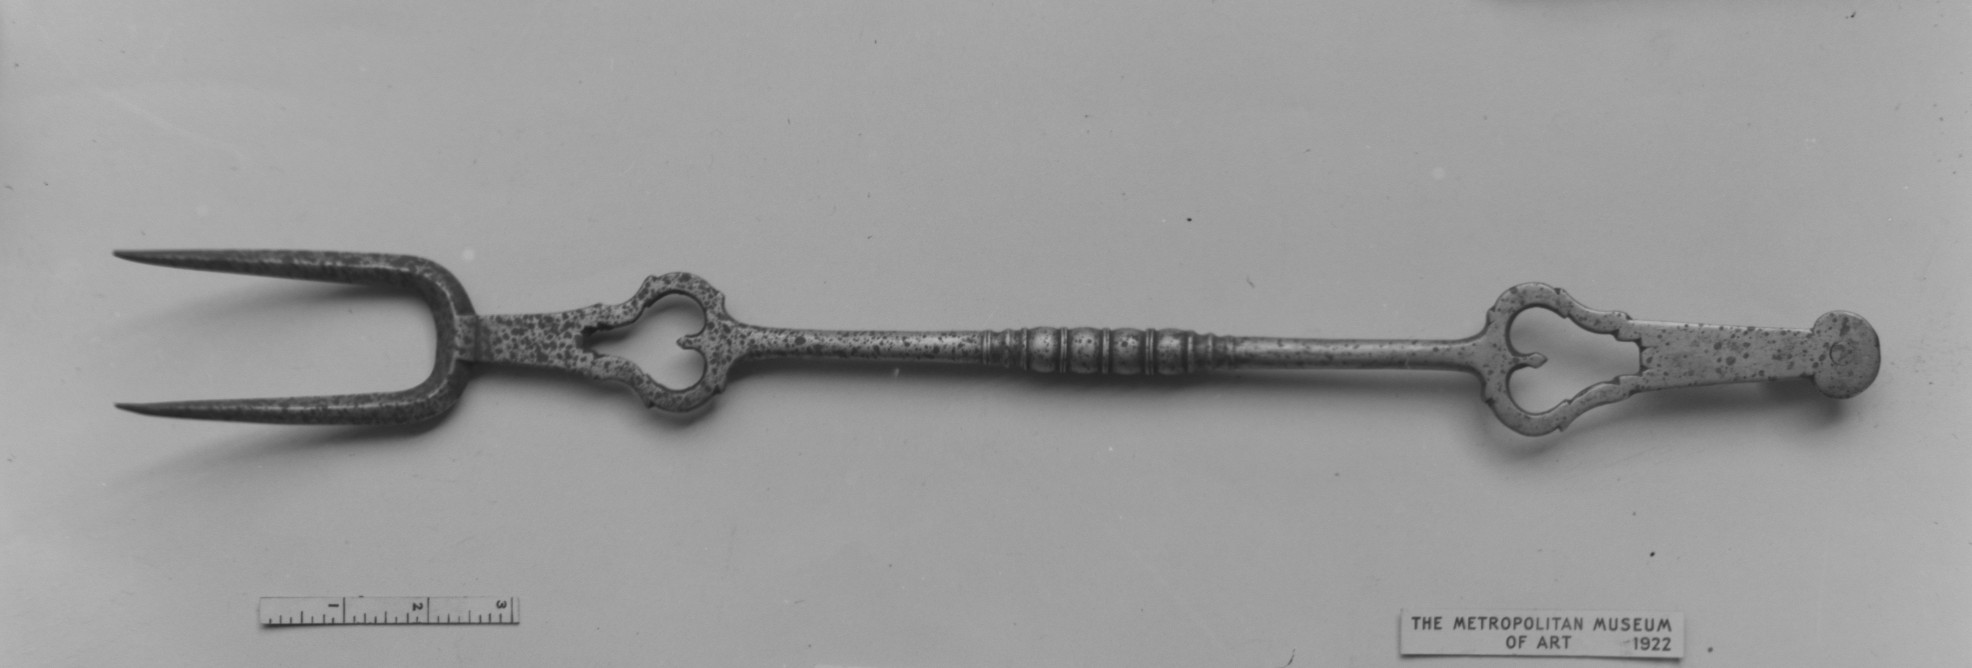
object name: meat fork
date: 1701-1800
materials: steel